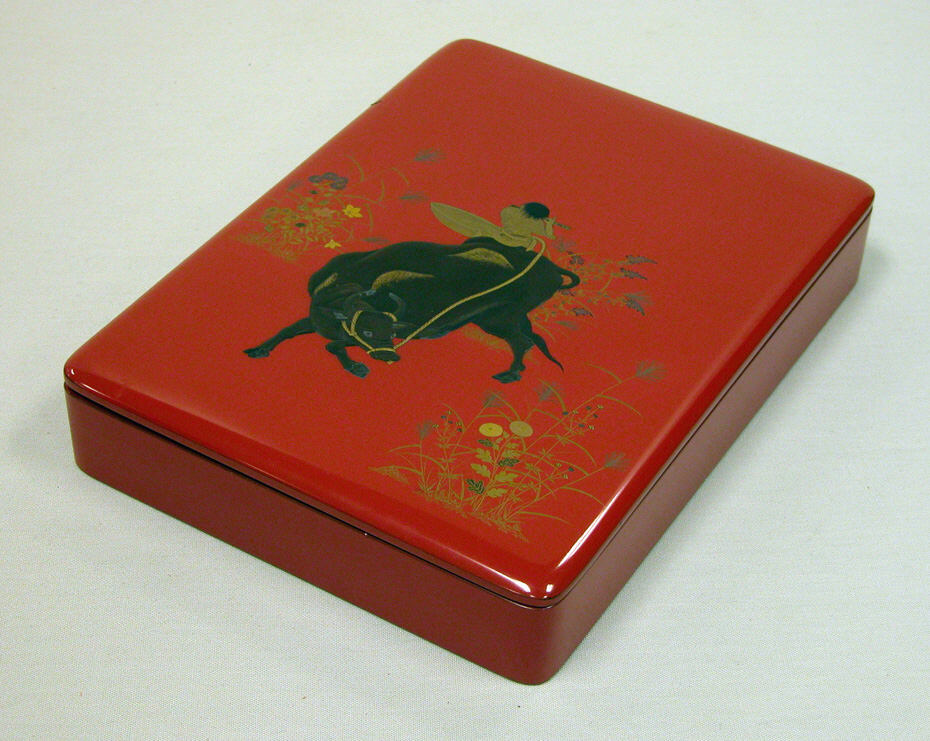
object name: writing box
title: Writing Box with Design of Ox-Herding Boy Playing Flute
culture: japanese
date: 1801-1900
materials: gold, lacquer, silver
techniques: maki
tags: boys,flutes,ox